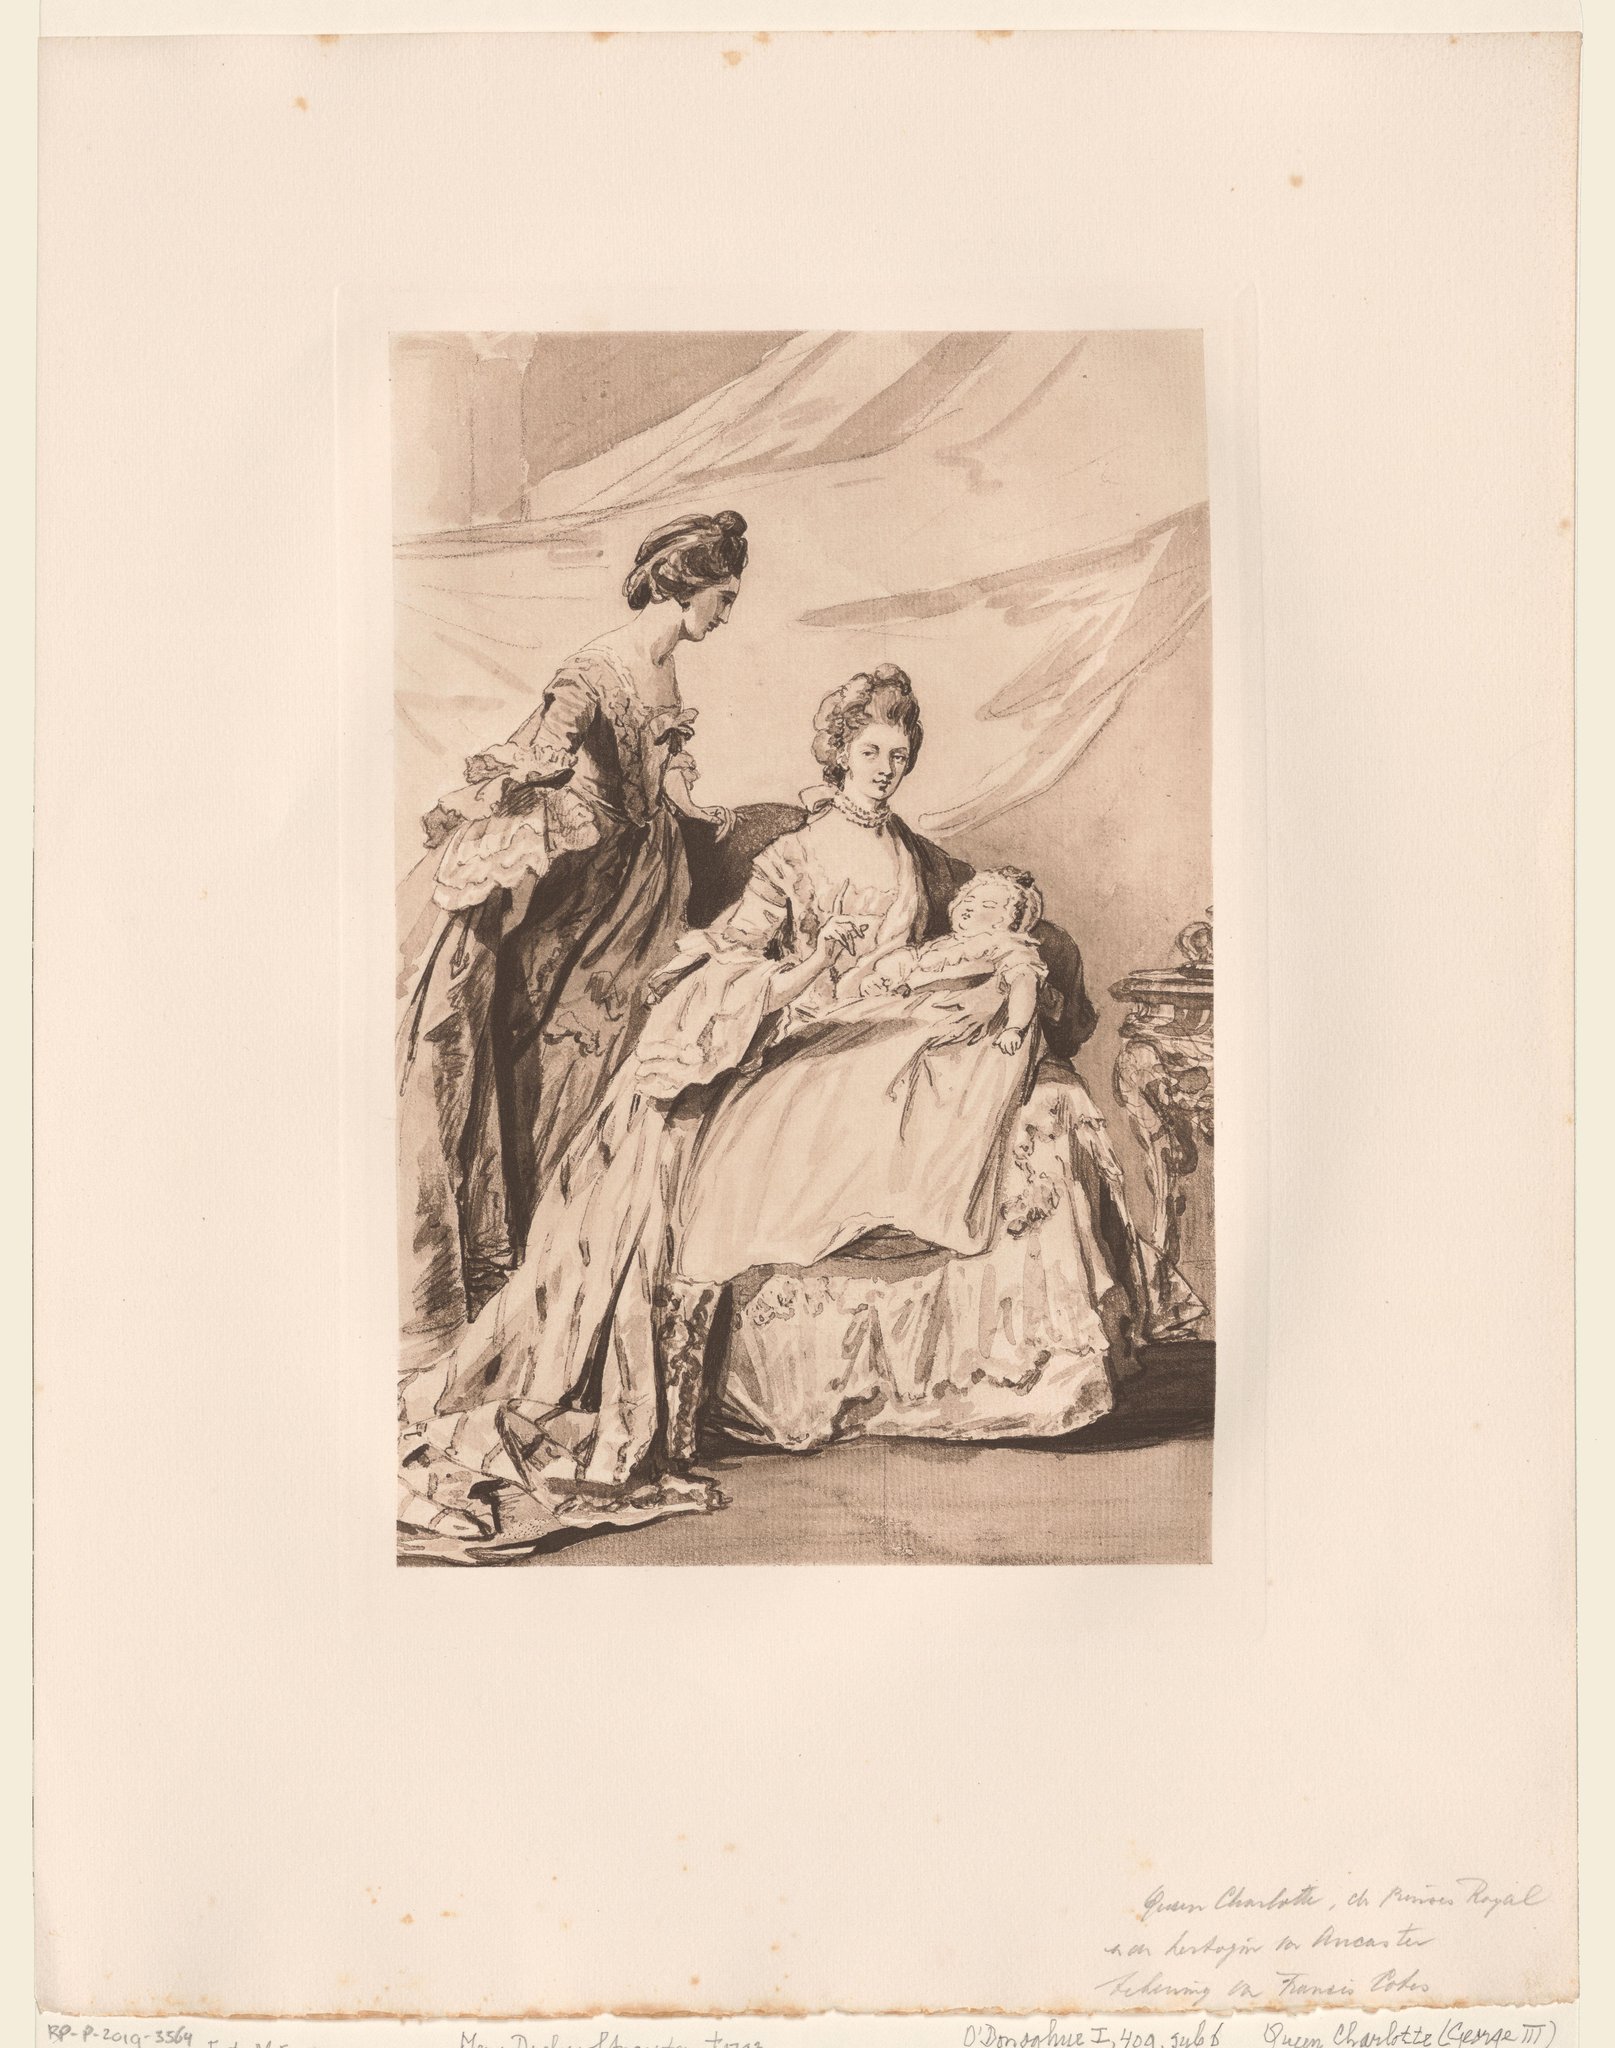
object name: photomechanical print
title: Groepsportret van Charlotte van Mecklenburg, koningin van Engeland, met prinses Charlotte en Mary Bertie, hertogin van Ancaster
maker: Anonymous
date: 1850-1899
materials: paper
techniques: photoaquatint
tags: london, charlotte van mecklenburg (koningin van groot-brittannië en ierland), historical persons - bb - woman, ruler, sovereign - bb - female ruler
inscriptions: collector's mark: Lugt 2228